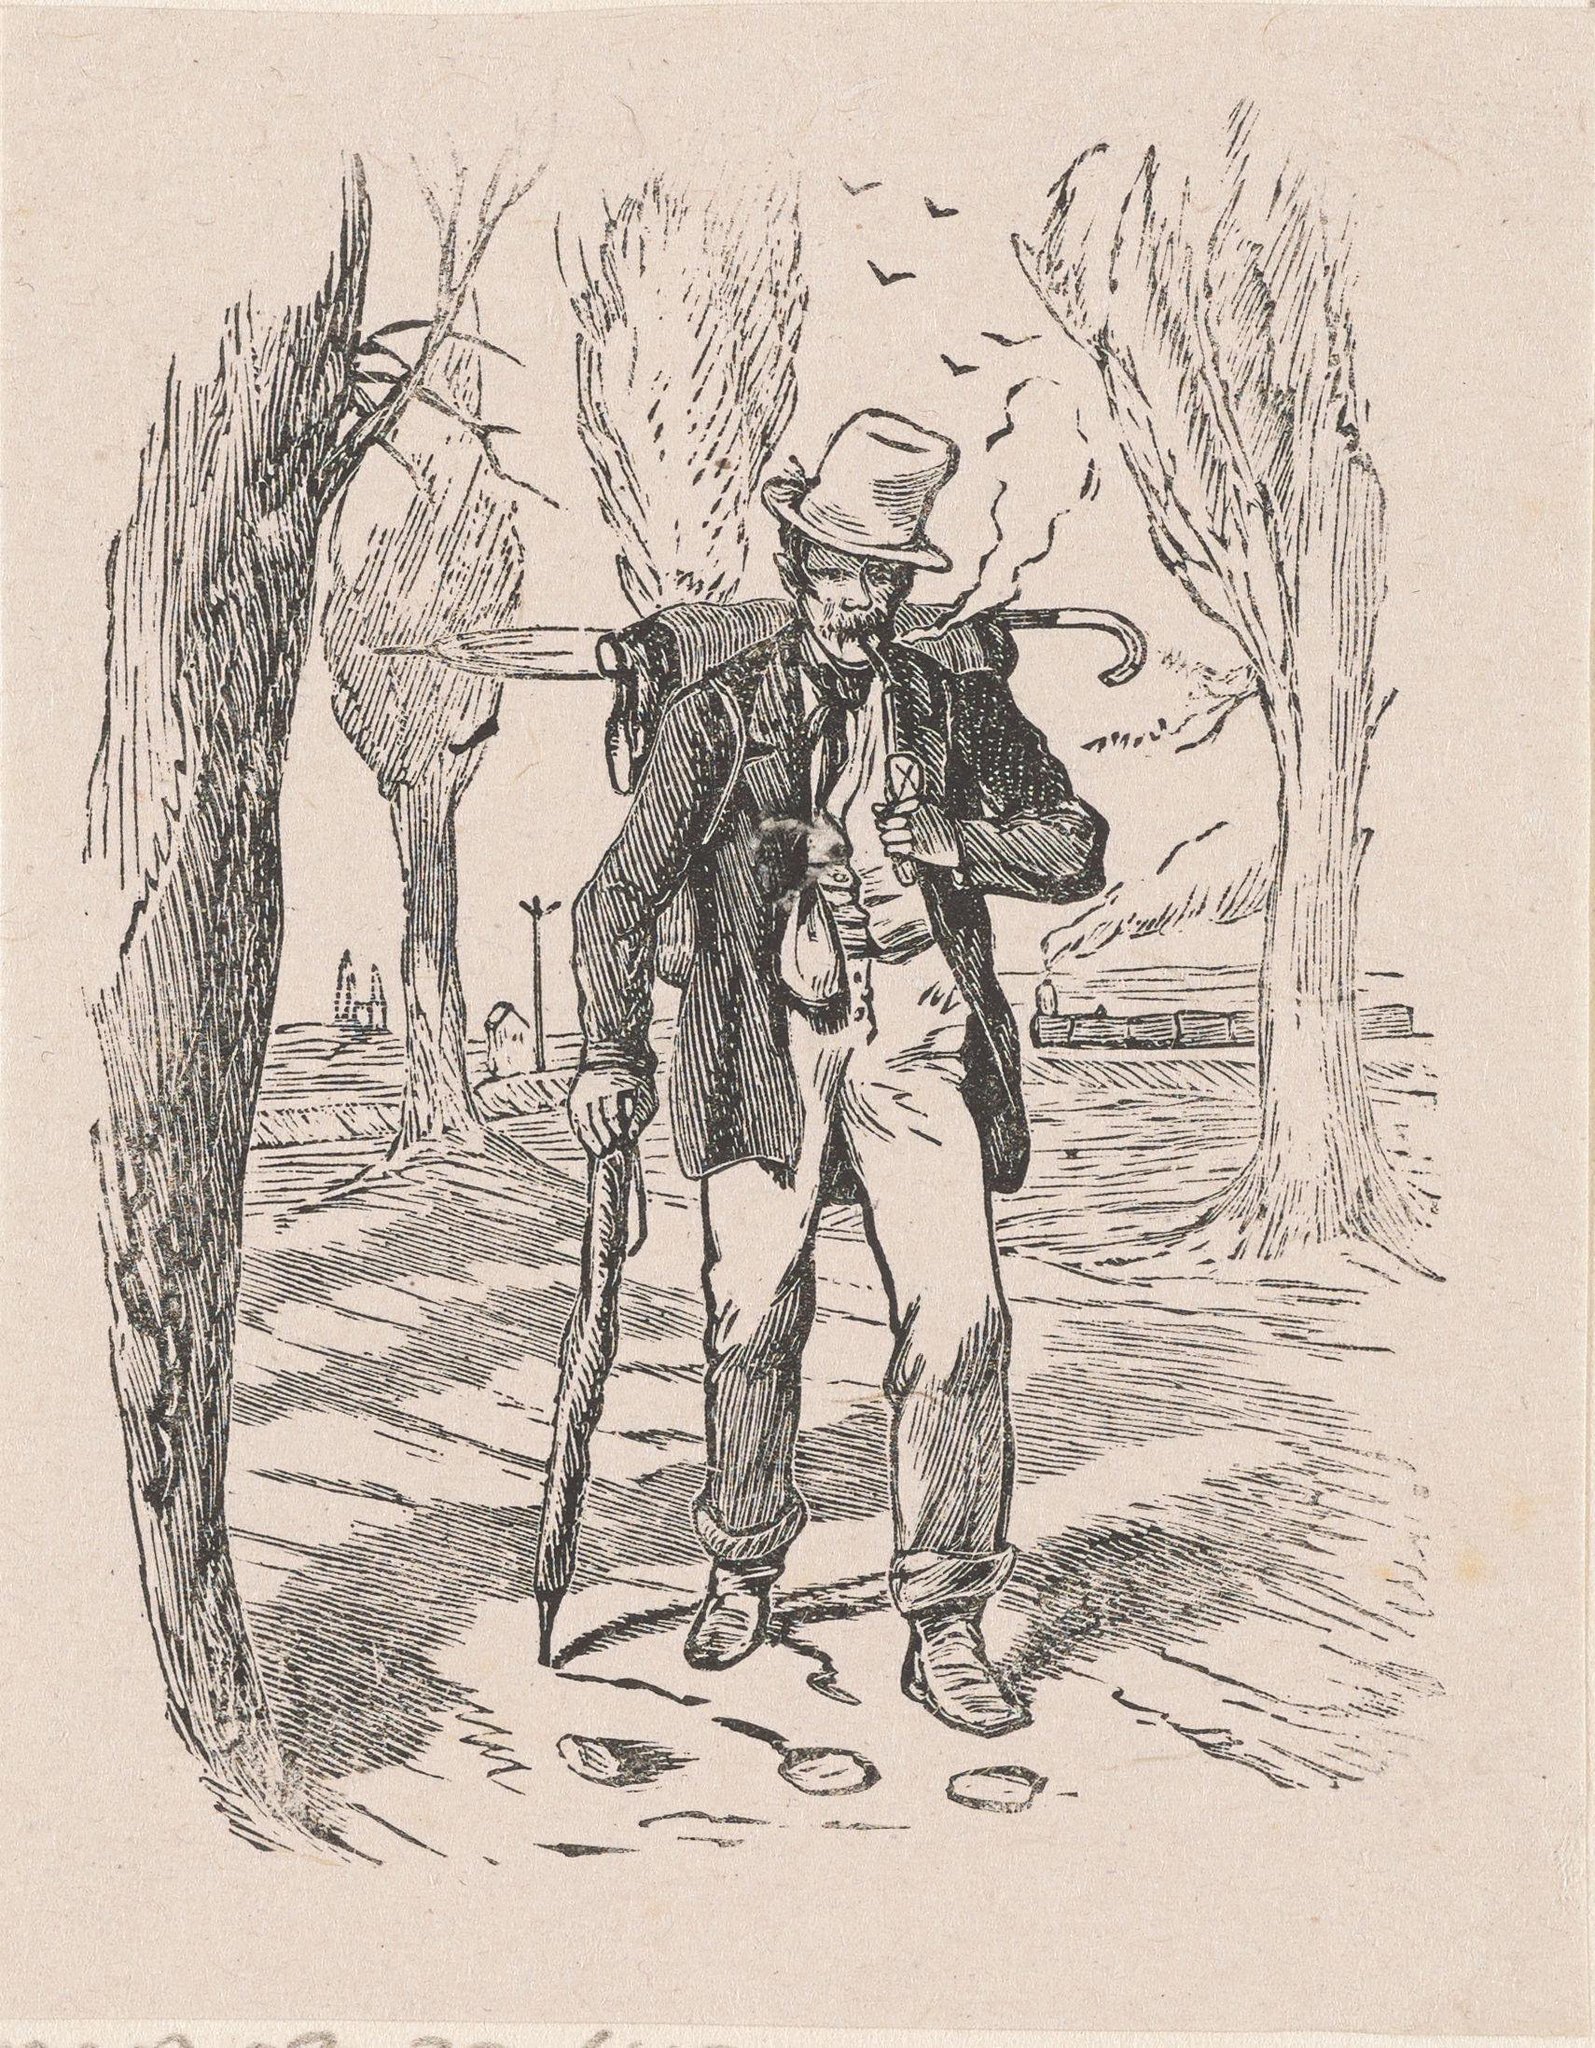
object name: print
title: Lopende man met een rugzak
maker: isaac weissenbruch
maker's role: print maker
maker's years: 1826-1912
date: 1836-1912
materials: paper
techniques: engraving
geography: netherlands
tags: adult man, walking, knapsack, rucksack